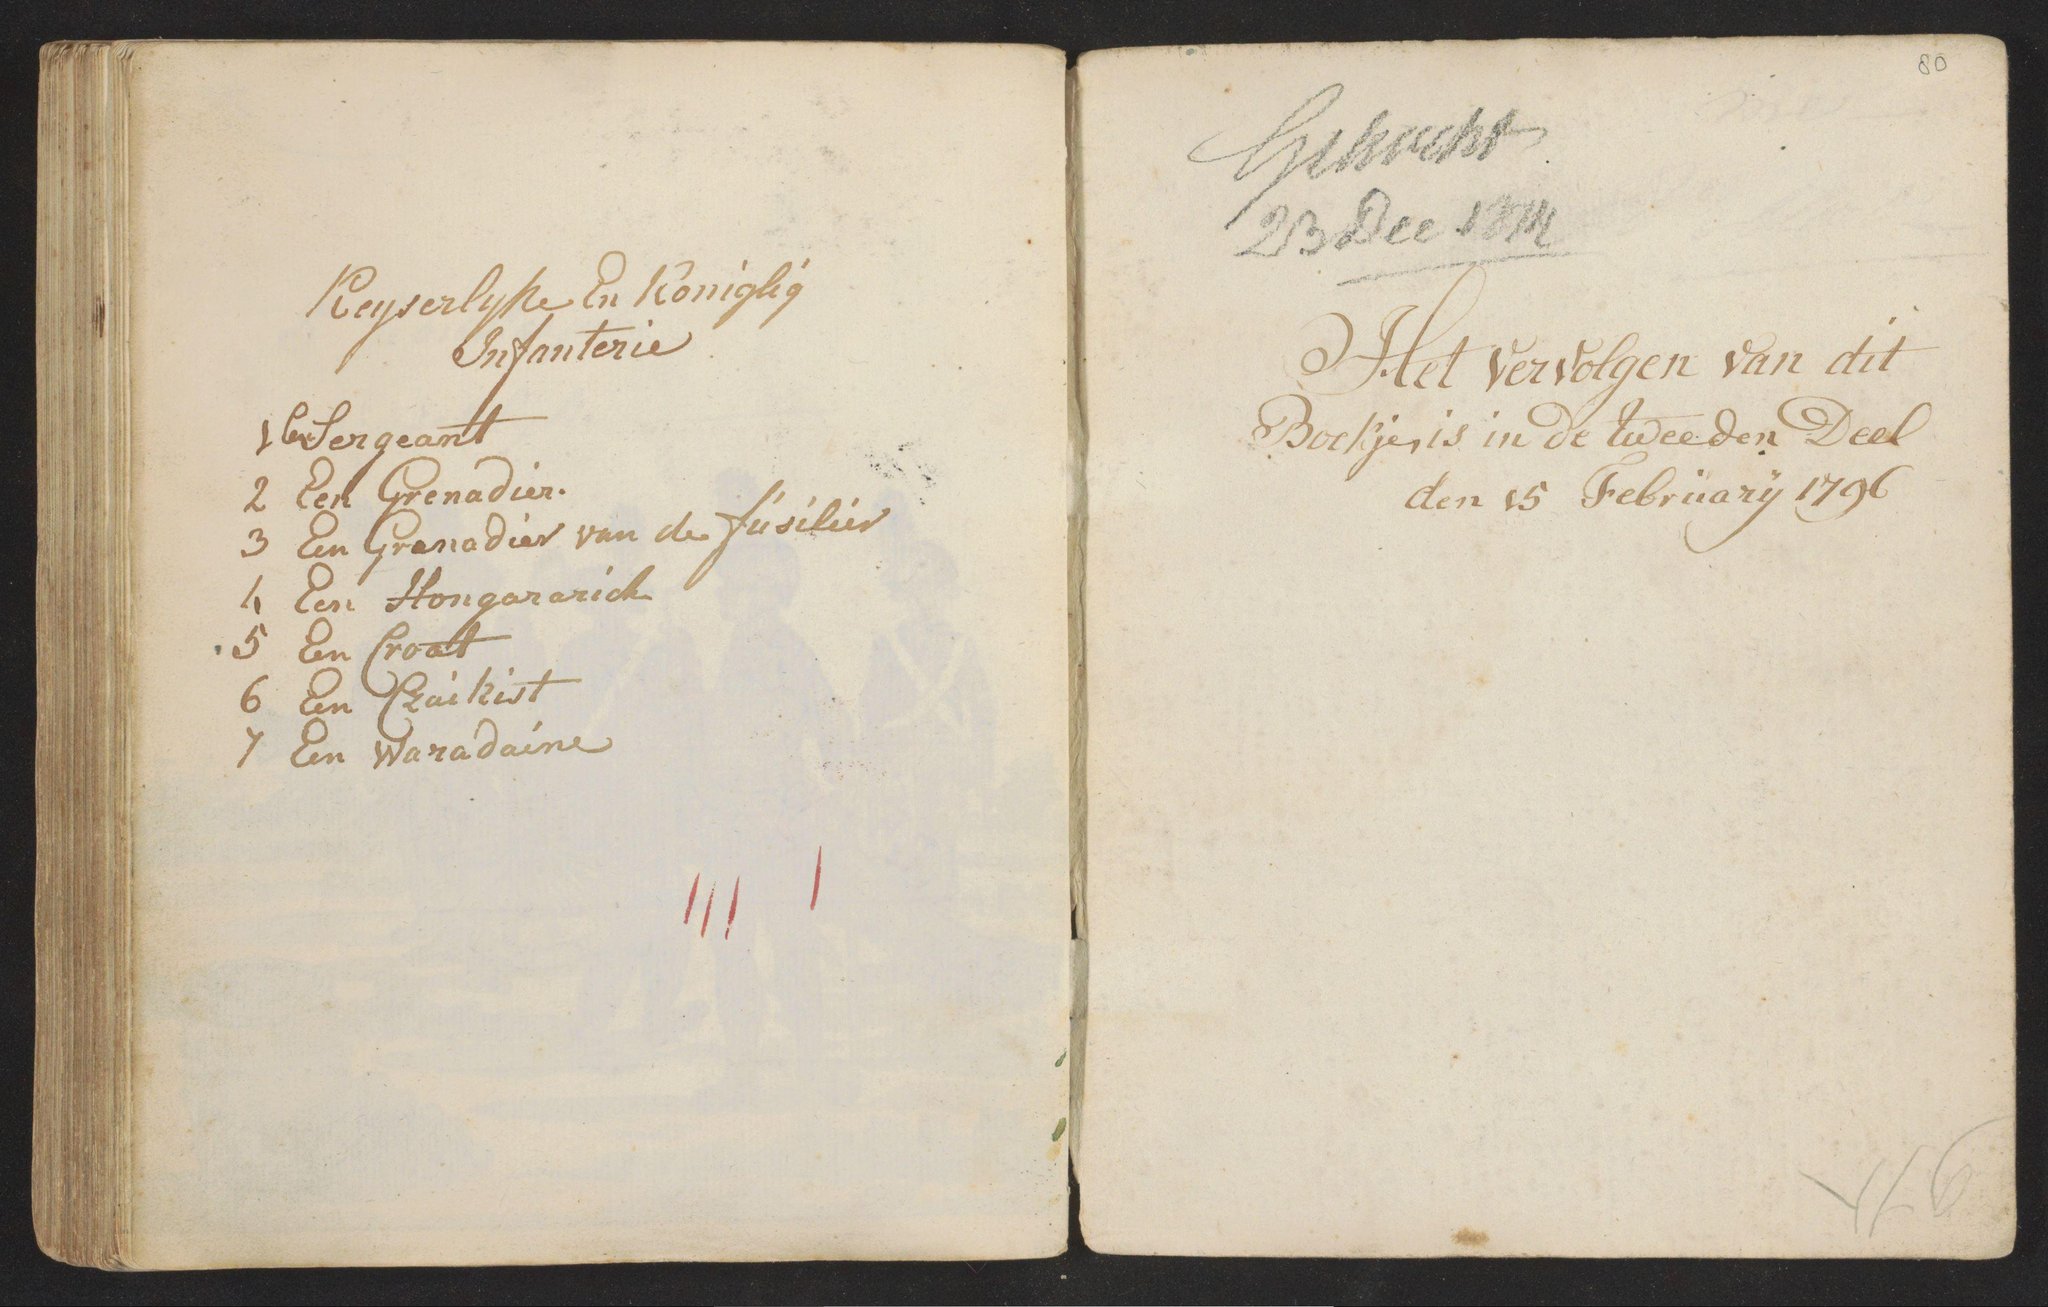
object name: manuscript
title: Keyserlyke en Koniglig Infanterie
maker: s.g. casten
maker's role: draughtsman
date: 1796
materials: paper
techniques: writing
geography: amsterdam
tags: patriots (1780-1795)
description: Twee bladzijden met handschrift. Links behorend bij een ontbrekende tekening, rechts een verwijzing naar het vervolg van dit album in een tweede deel op 15 februari 1796. Hier is blad uit het album gescheurd. Onderdeel van het derde hoofdstuk over de nieuwe uniformen in de periode na het herstel van de prins van Oranje en de komst van de Pruisische troepen in Holland in 1787. In het schetsboek met gekleurde tekeningen van de uniformen van militairen en leden van de schutterij uit de periode 1770 tot 1795-1796.